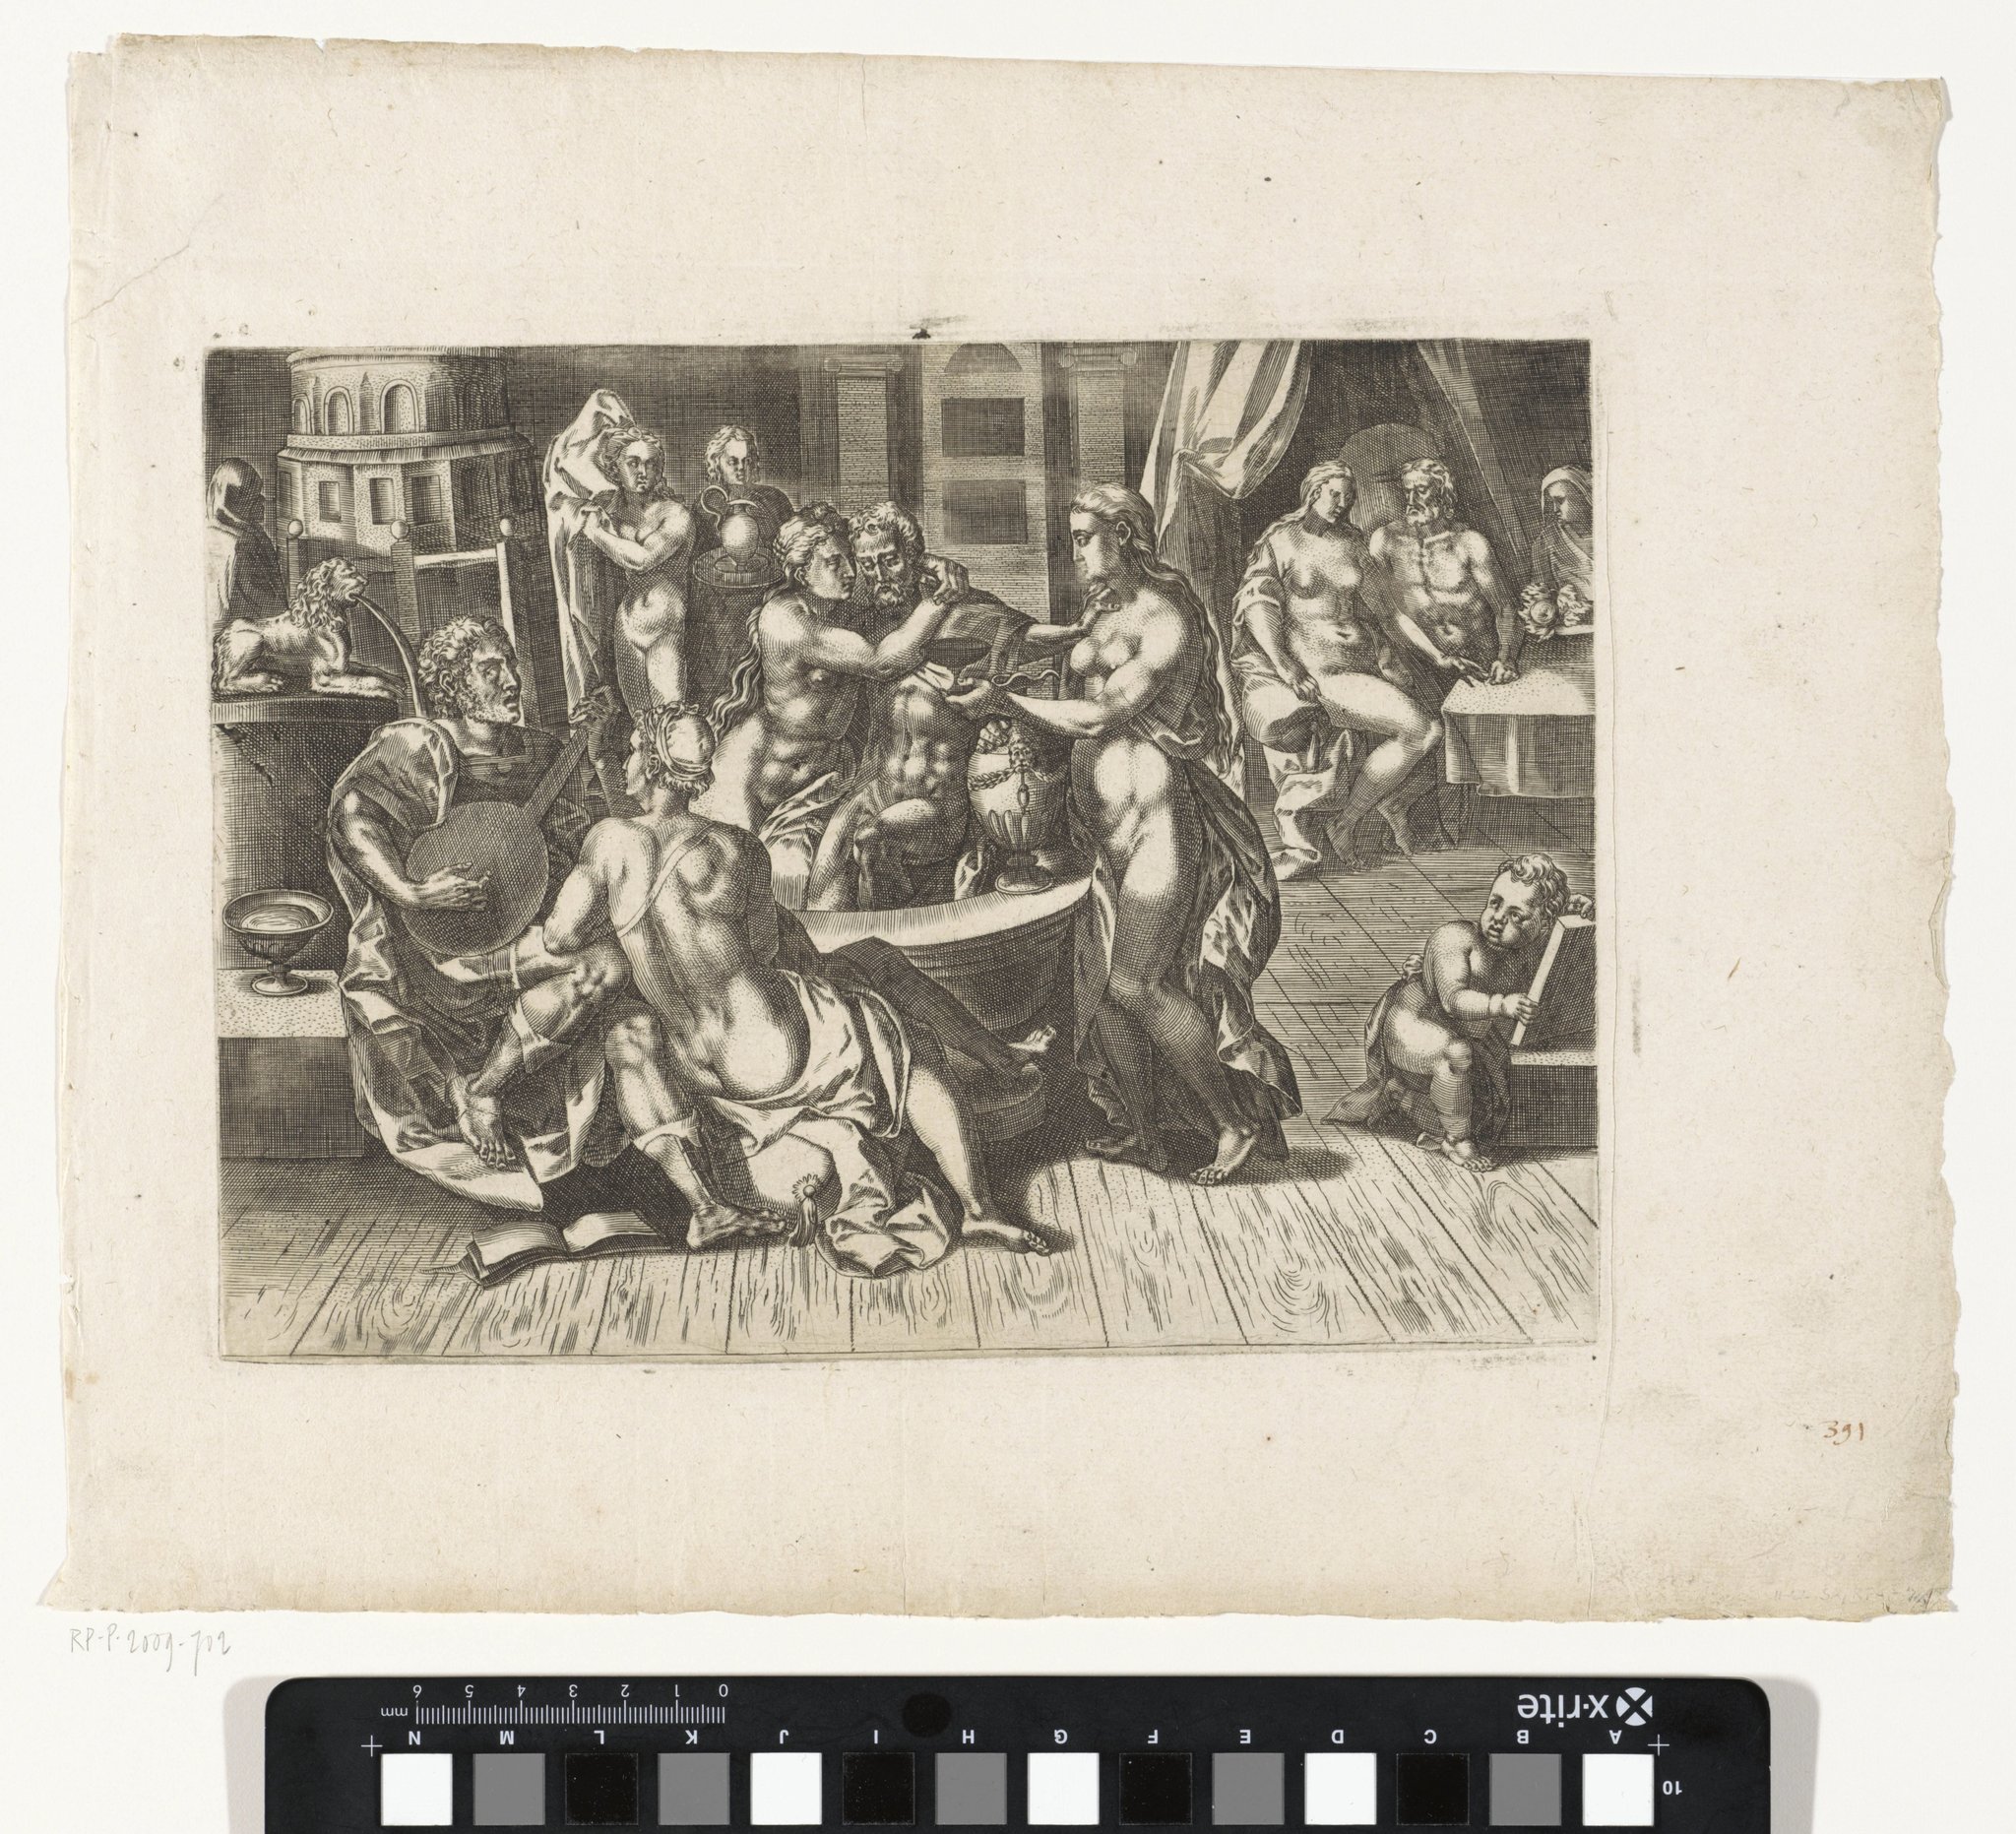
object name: print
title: Scène in bordeel met badende man en vrouwen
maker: Anonymous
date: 1500-1599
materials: paper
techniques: engraving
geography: antwerp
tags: taking a bath, brothel, (story of) sardanapalus - love-affairs of person from classical history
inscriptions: collector's mark: Lugt 2228, collector's mark: Lugt 2760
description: Bordeelscène met op voorgrond man in bad geflankeerd door twee vrouwen. Linksvoor twee figuren waarvan één met luit. Rechts een putto en daarachter zittend stel aan tafel. (Sardanpolus in het bad ?)